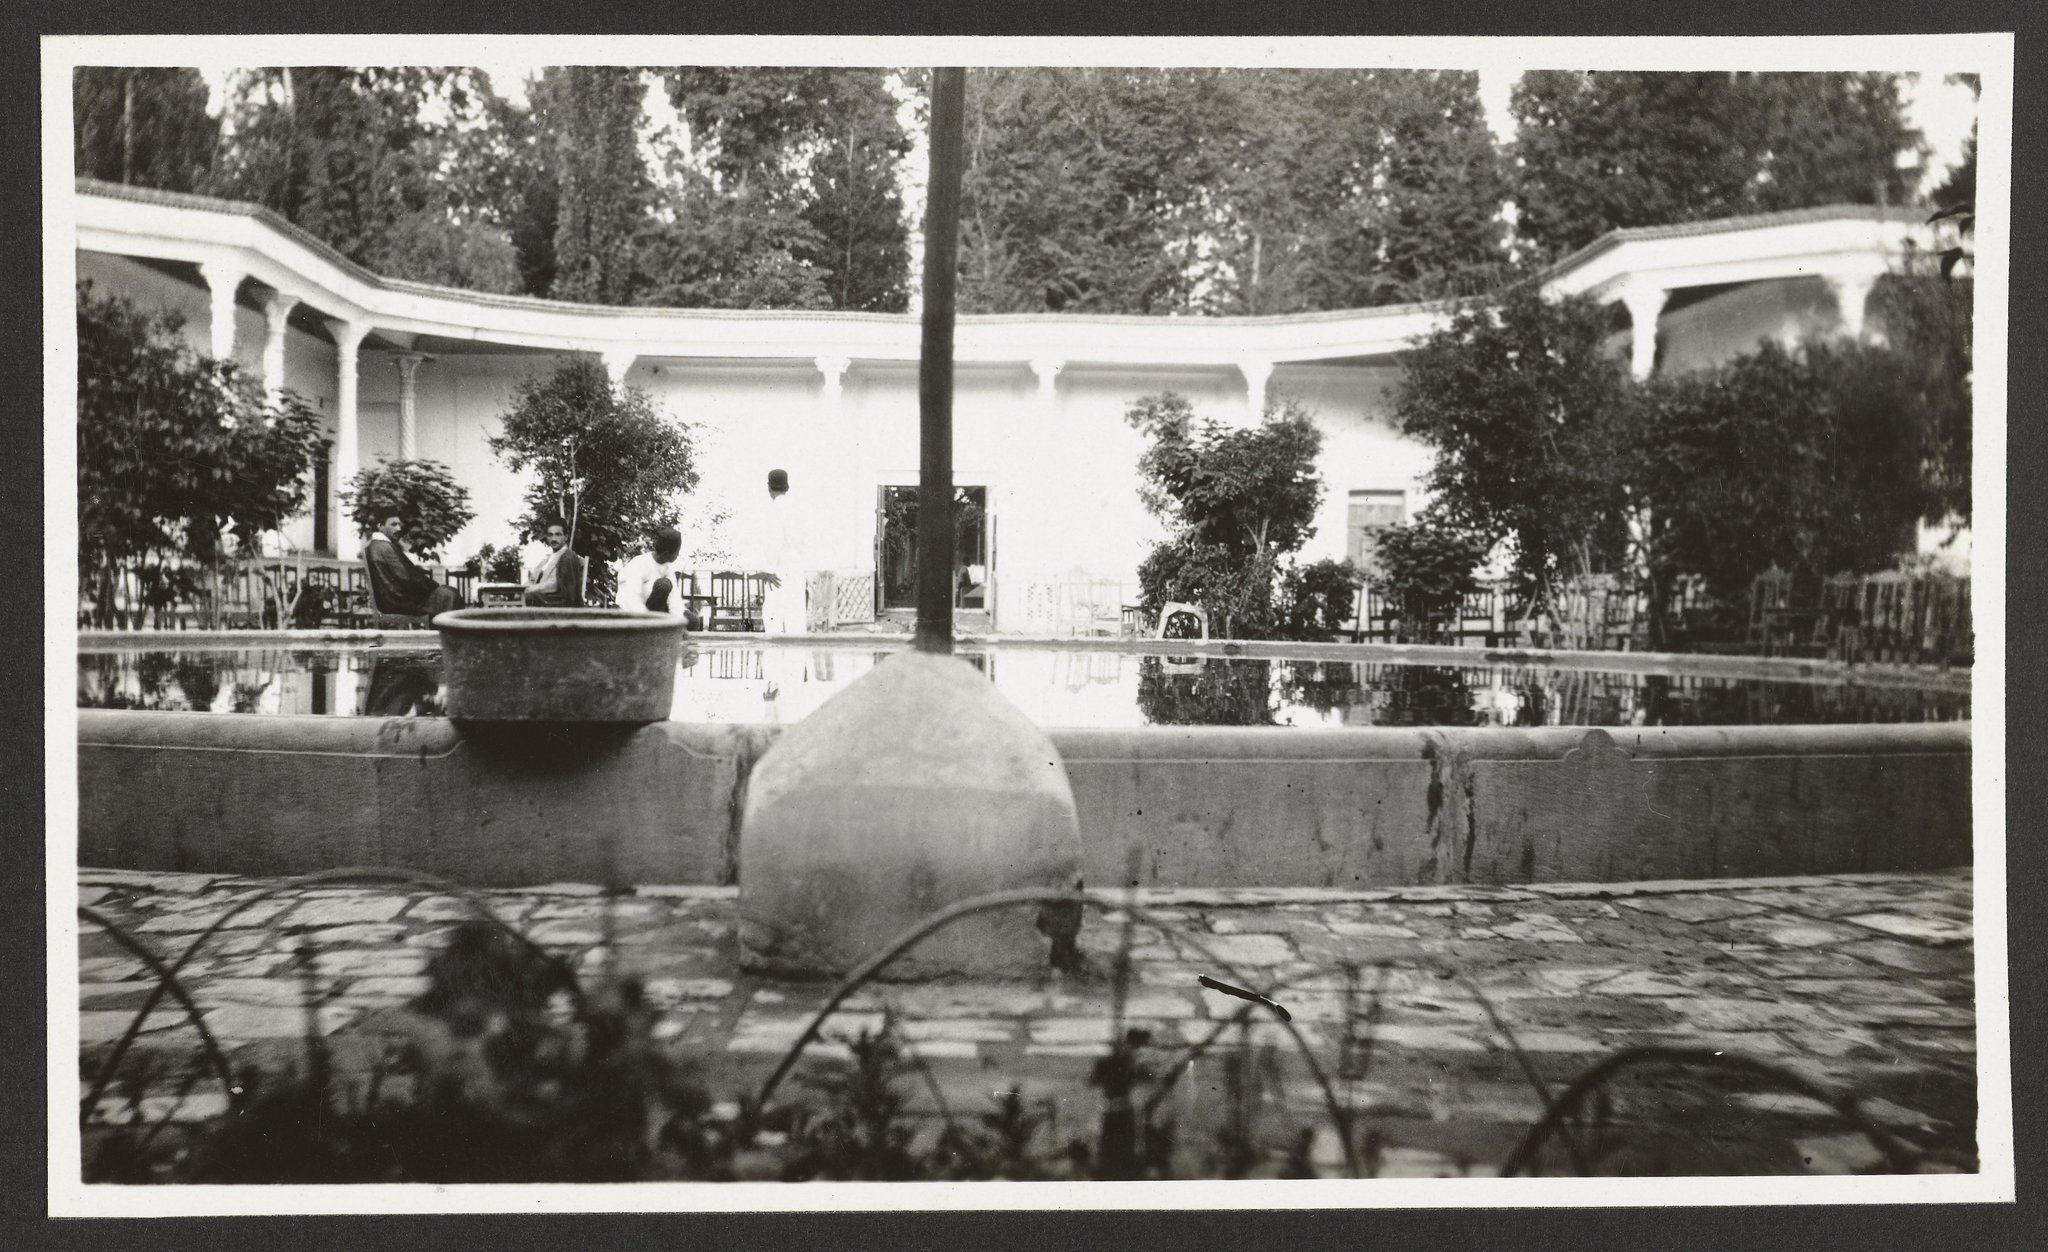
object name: photograph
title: Tuin met waterkom, van het hotel Xhar Bagh.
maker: a.g.a. van eelde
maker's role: engineer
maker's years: 1862-1950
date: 1925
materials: cardboard, paper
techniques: gelatin silver print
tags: iran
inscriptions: number: ‘25.’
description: Titel op object afkomstig uit inventaris (Verklaring der Photo's) behorend bij het album.